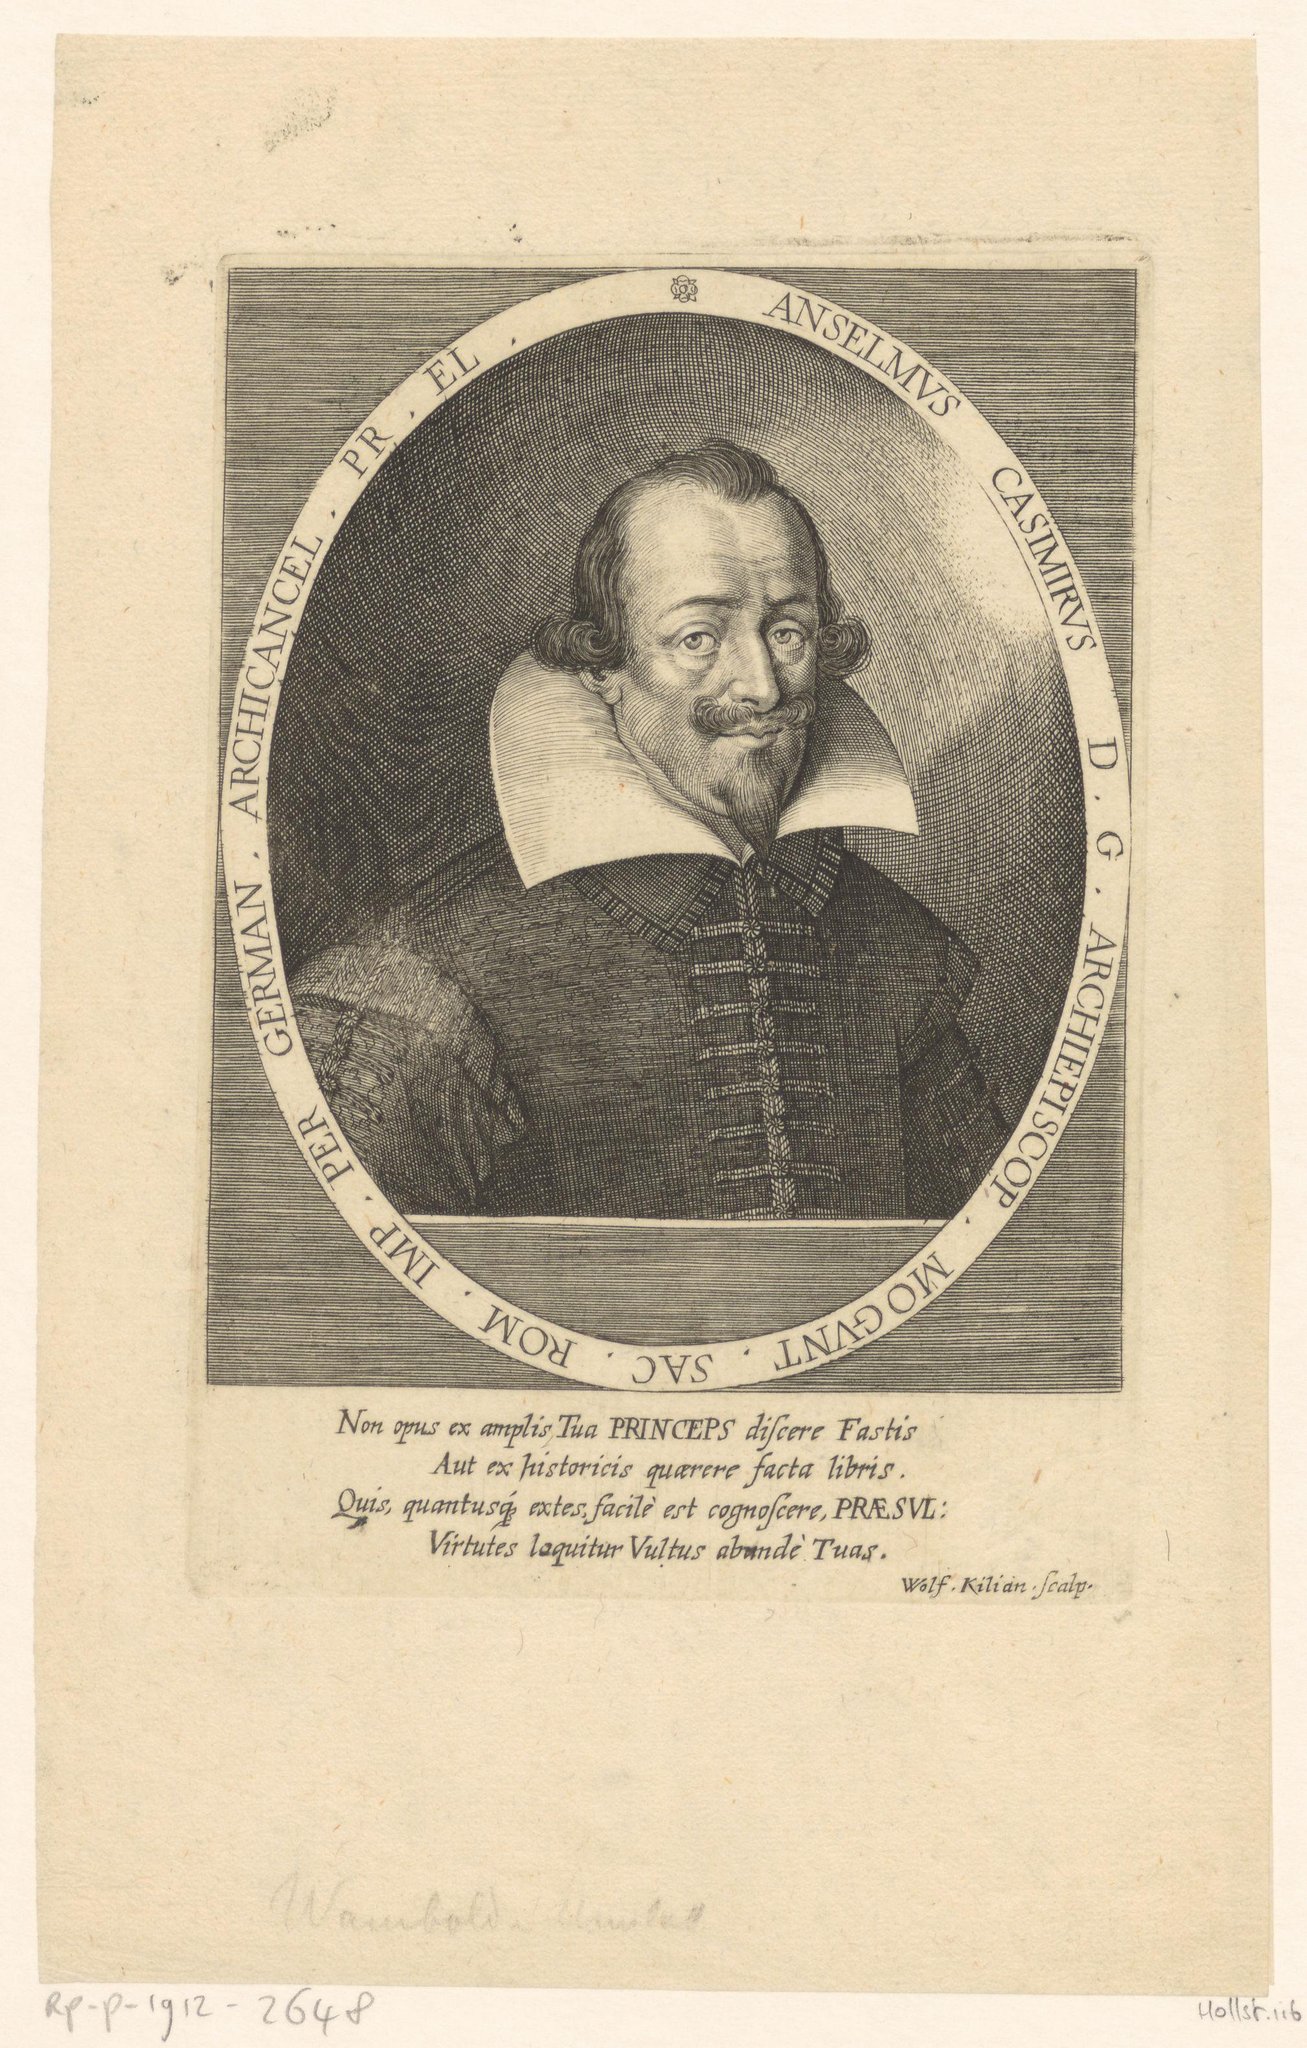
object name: print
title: Portret van Anselm Casimir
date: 1591-1662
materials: paper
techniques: engraving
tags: historical persons, regent, substitute ruler; viceroy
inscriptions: collector's mark: Lugt 2228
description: Tekst in het Latijn in de omlijsting en in de ondermarge.